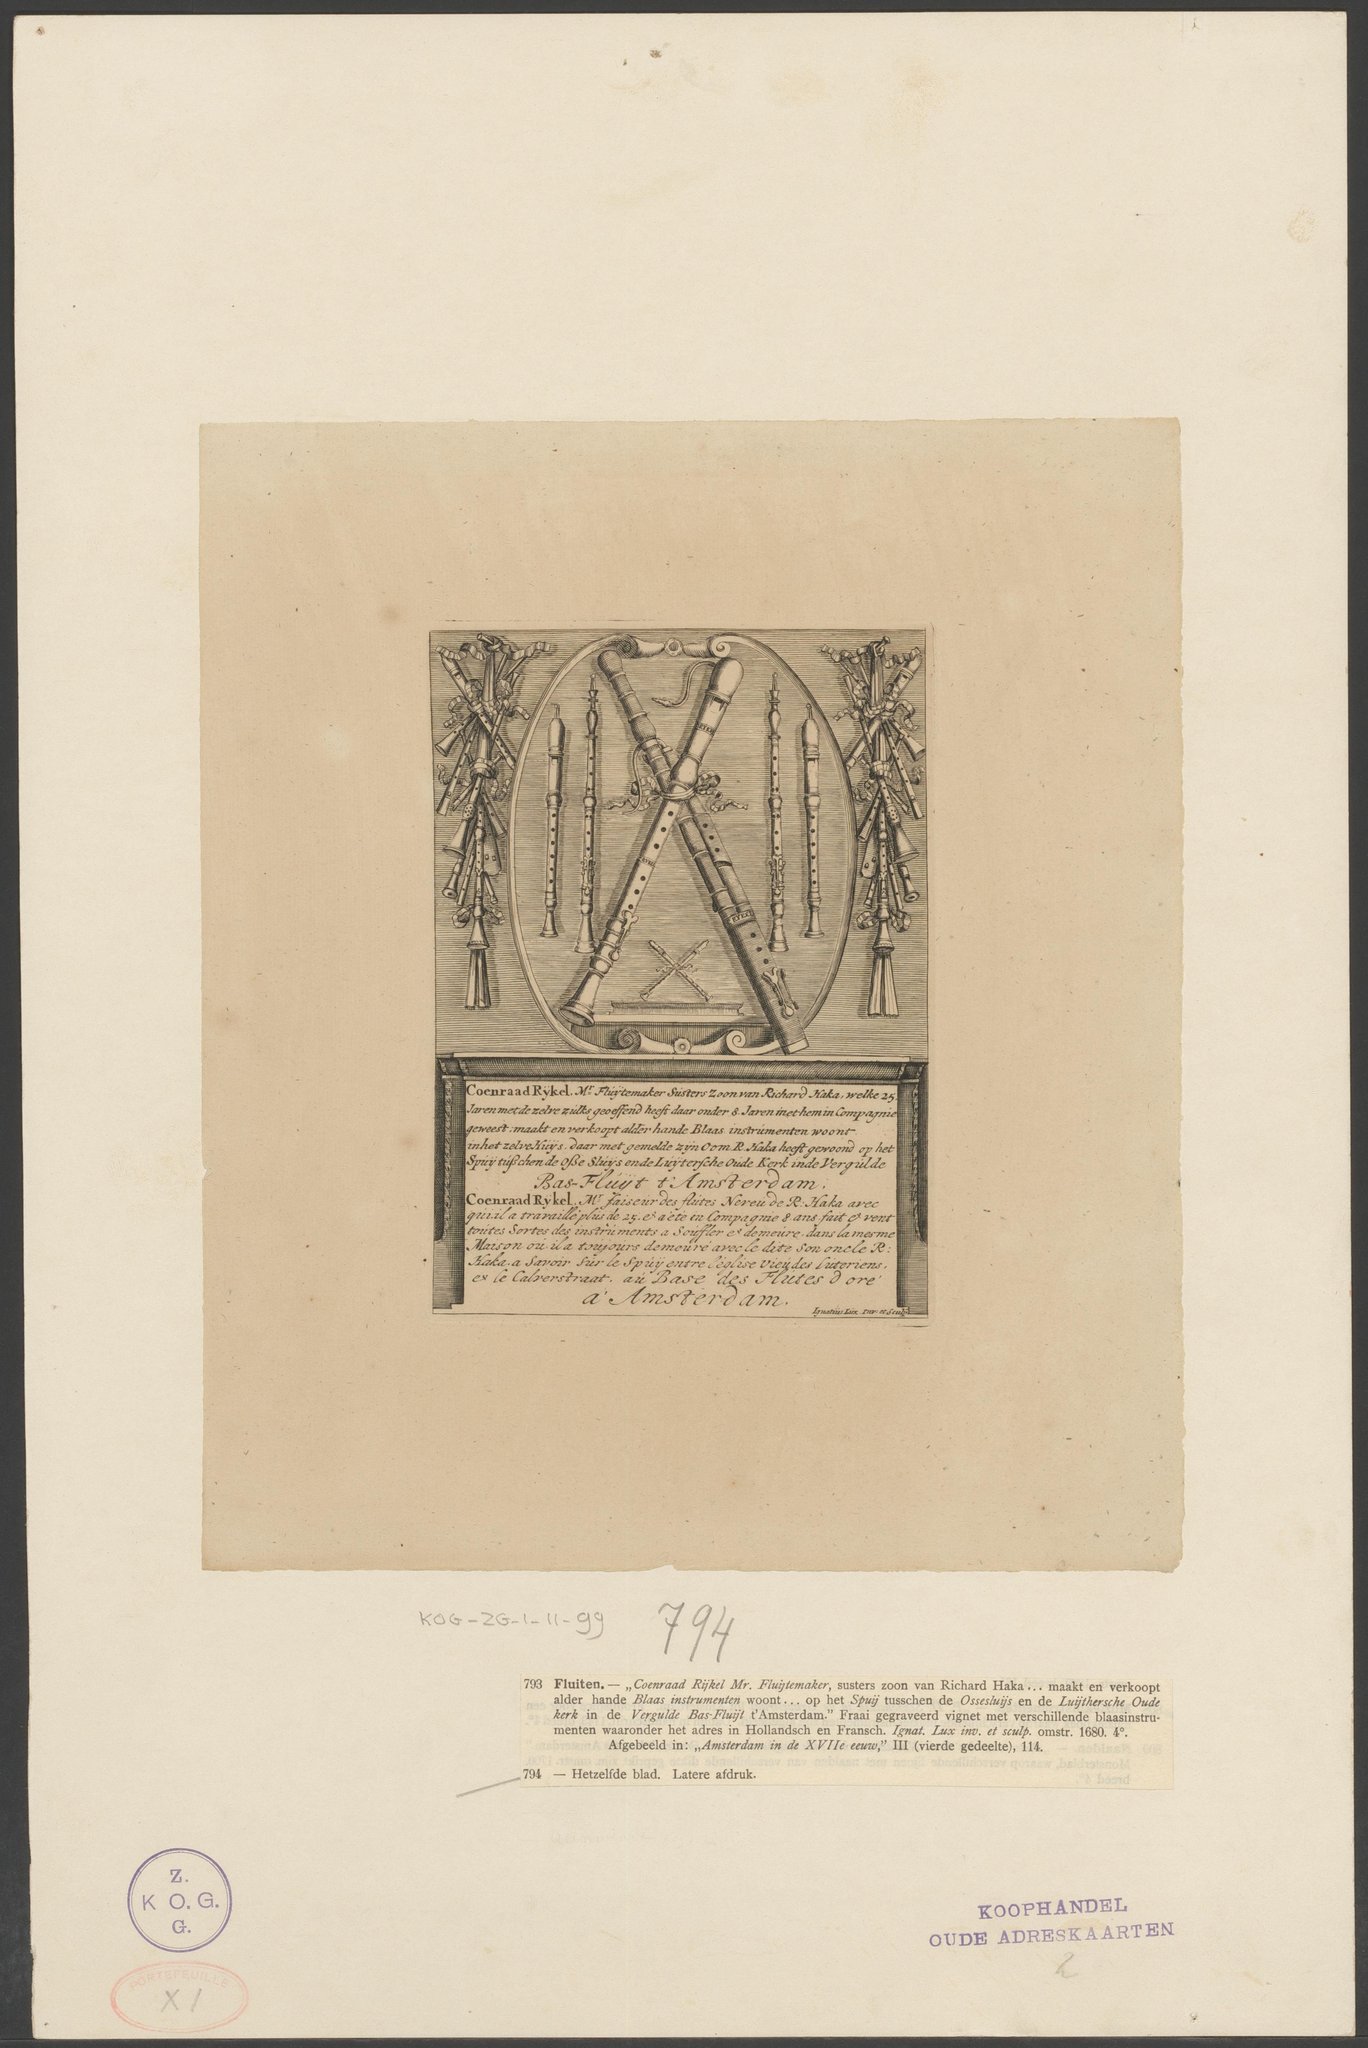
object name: print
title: Adreskaart van de muziekinstrumentenmaker Coenraad Rijkel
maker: ignatius lux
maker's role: draughtsman, print maker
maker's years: 1649-1713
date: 1800-1899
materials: paper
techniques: engraving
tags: musical instrument maker, coenraad rijkel, flute, aulos, tibia, amsterdam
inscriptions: stamp, collector's mark: Lugt 1641, stamp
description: Adreskaart van de Vergulde Bas-Fluijt in Amsterdam van de muziekinstrumentenmaker Coenraad Rijkel. Acht verschillende blokfluiten in een ovaal, daarnaast links en rechts een decoratie in de vorm van een tros blokfluiten. Onder de afbeelding Nederlandse en Franse tekst, de naam, achtergrond en adres van Coenraad Rijkel. Onderwerpsrubrieken binnen de Atlas Zeden en Gewoonten: Handel, nijverheid en verkeer, Koophandel, Veilingen, Makelaardij en Verzekeringswezen, Oude adreskaarten van winkels en fabrieken, reclame.